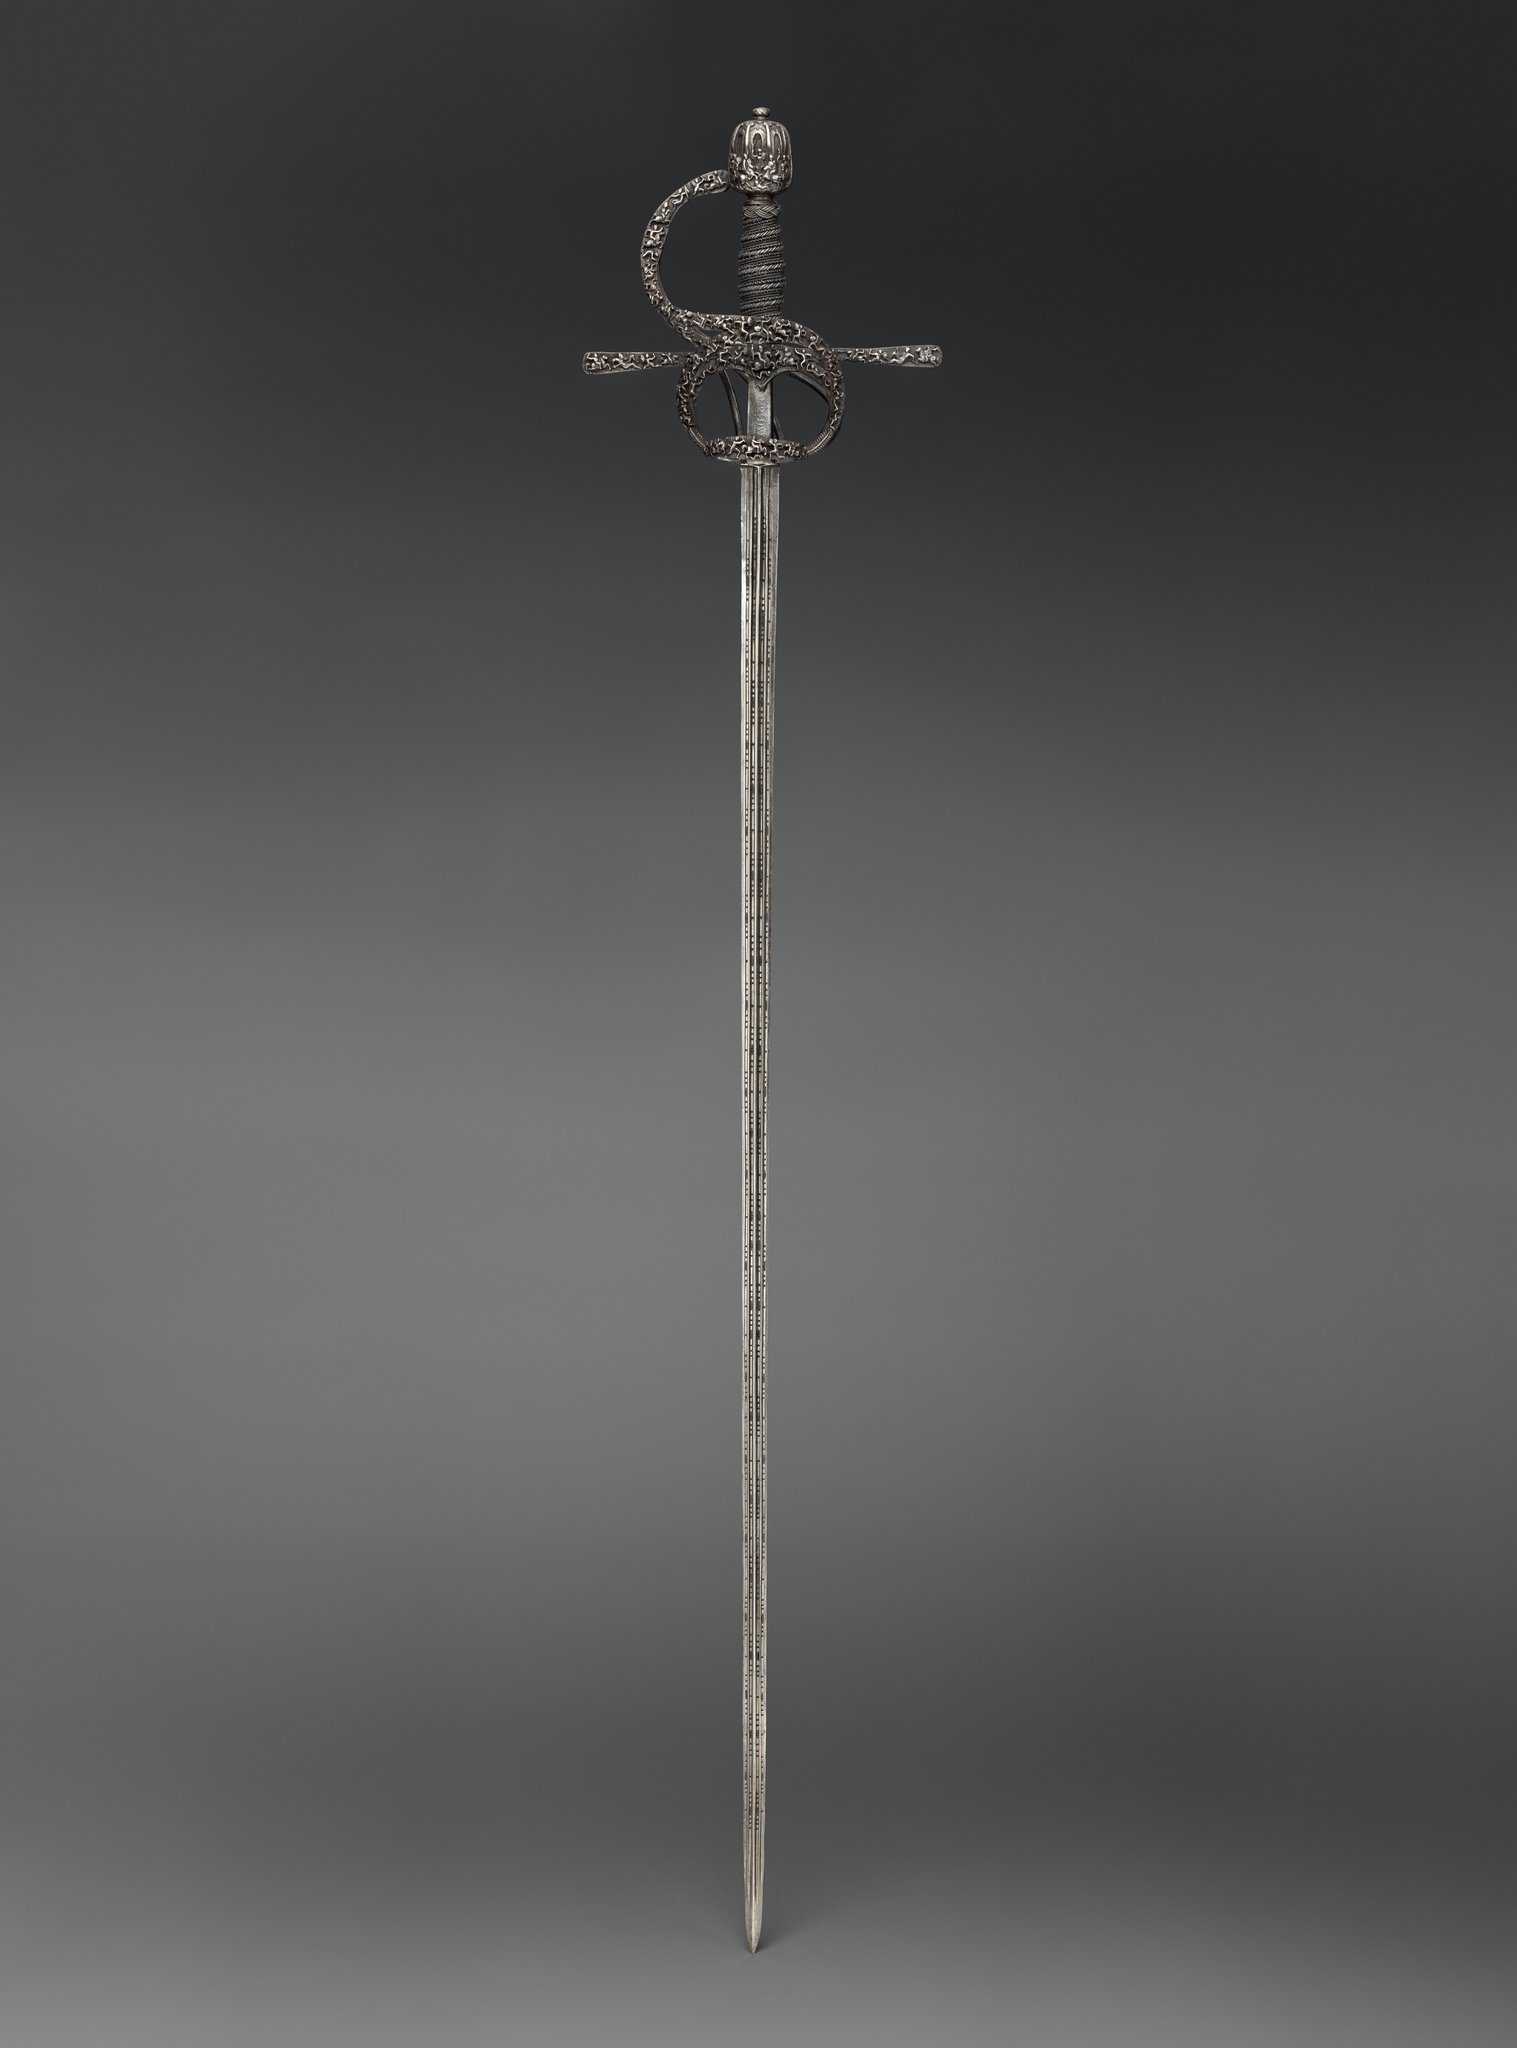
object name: rapier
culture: hilt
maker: pietro de formicano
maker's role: bladesmith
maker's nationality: italian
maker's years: 1575-1625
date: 1610-1620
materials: iron, steel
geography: italy